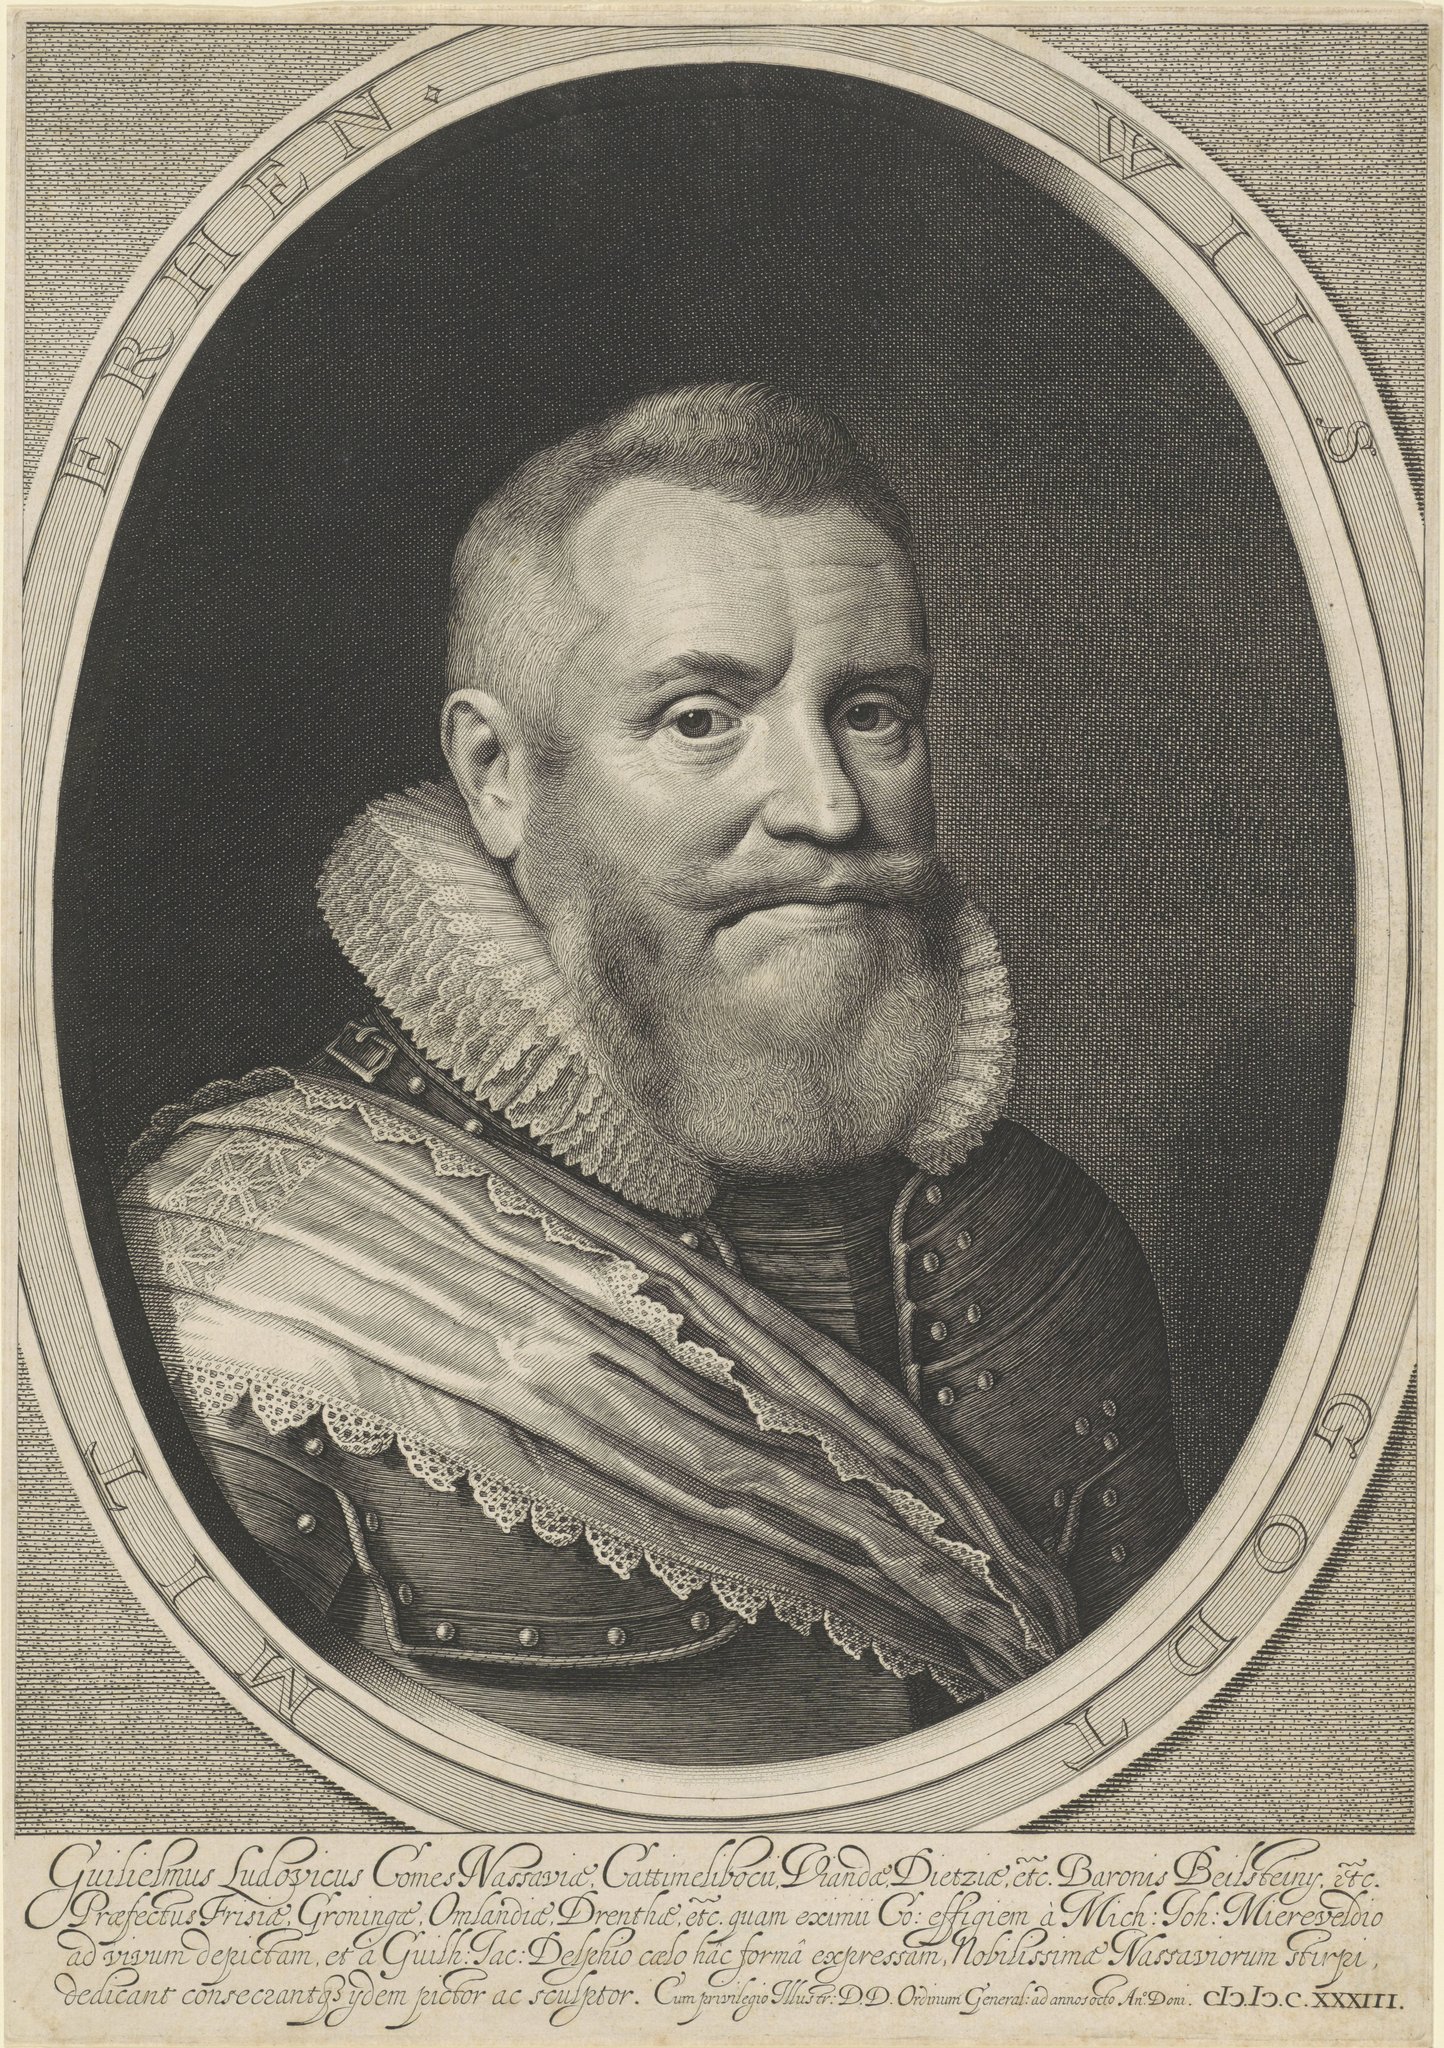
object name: print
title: Portret van Willem Lodewijk, graaf van Nassau-Dillenburg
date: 1633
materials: paper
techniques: engraving, etching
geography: delft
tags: willem lodewijk graaf van nassau-dillenburg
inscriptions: collector's mark: Lugt 963, collector's mark: Lugt 698, collector's mark: Lugt 2228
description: De hier vermelde titel verwijst naar de hoogst verkregen titel van de geportretteerde, niet per se naar de titel die de geportretteerde op deze voorstelling draagt.